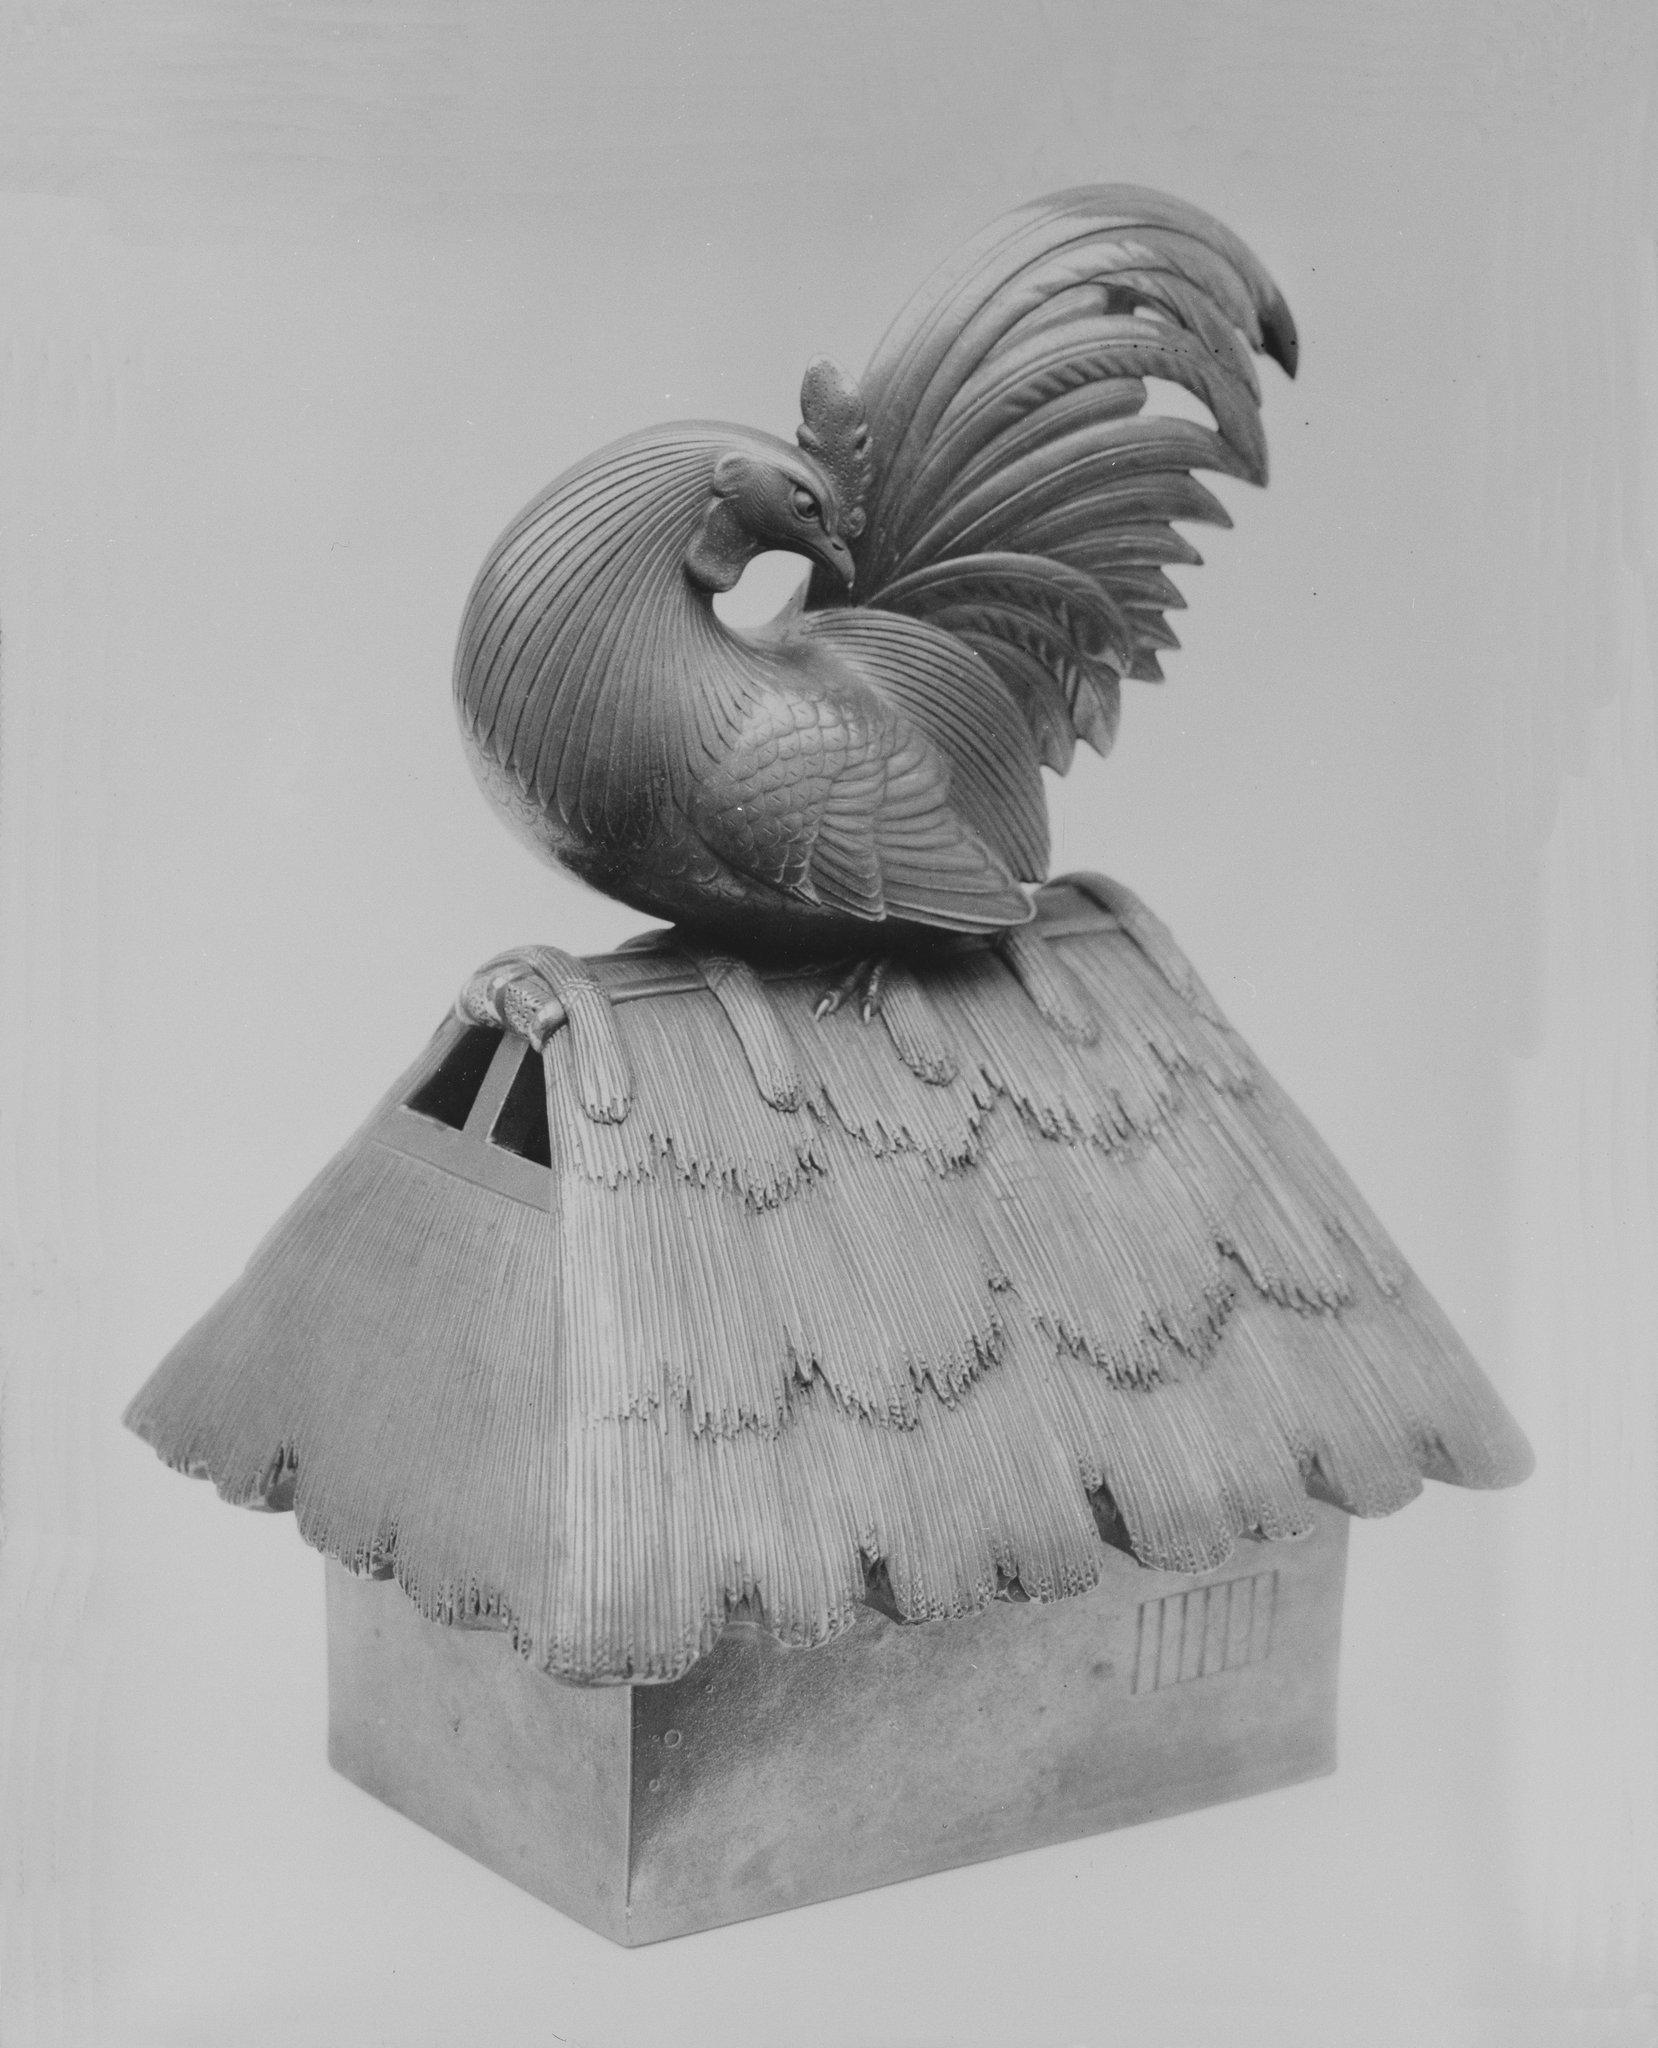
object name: incense burner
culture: japanese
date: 1800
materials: glaze, stoneware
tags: houses,roosters